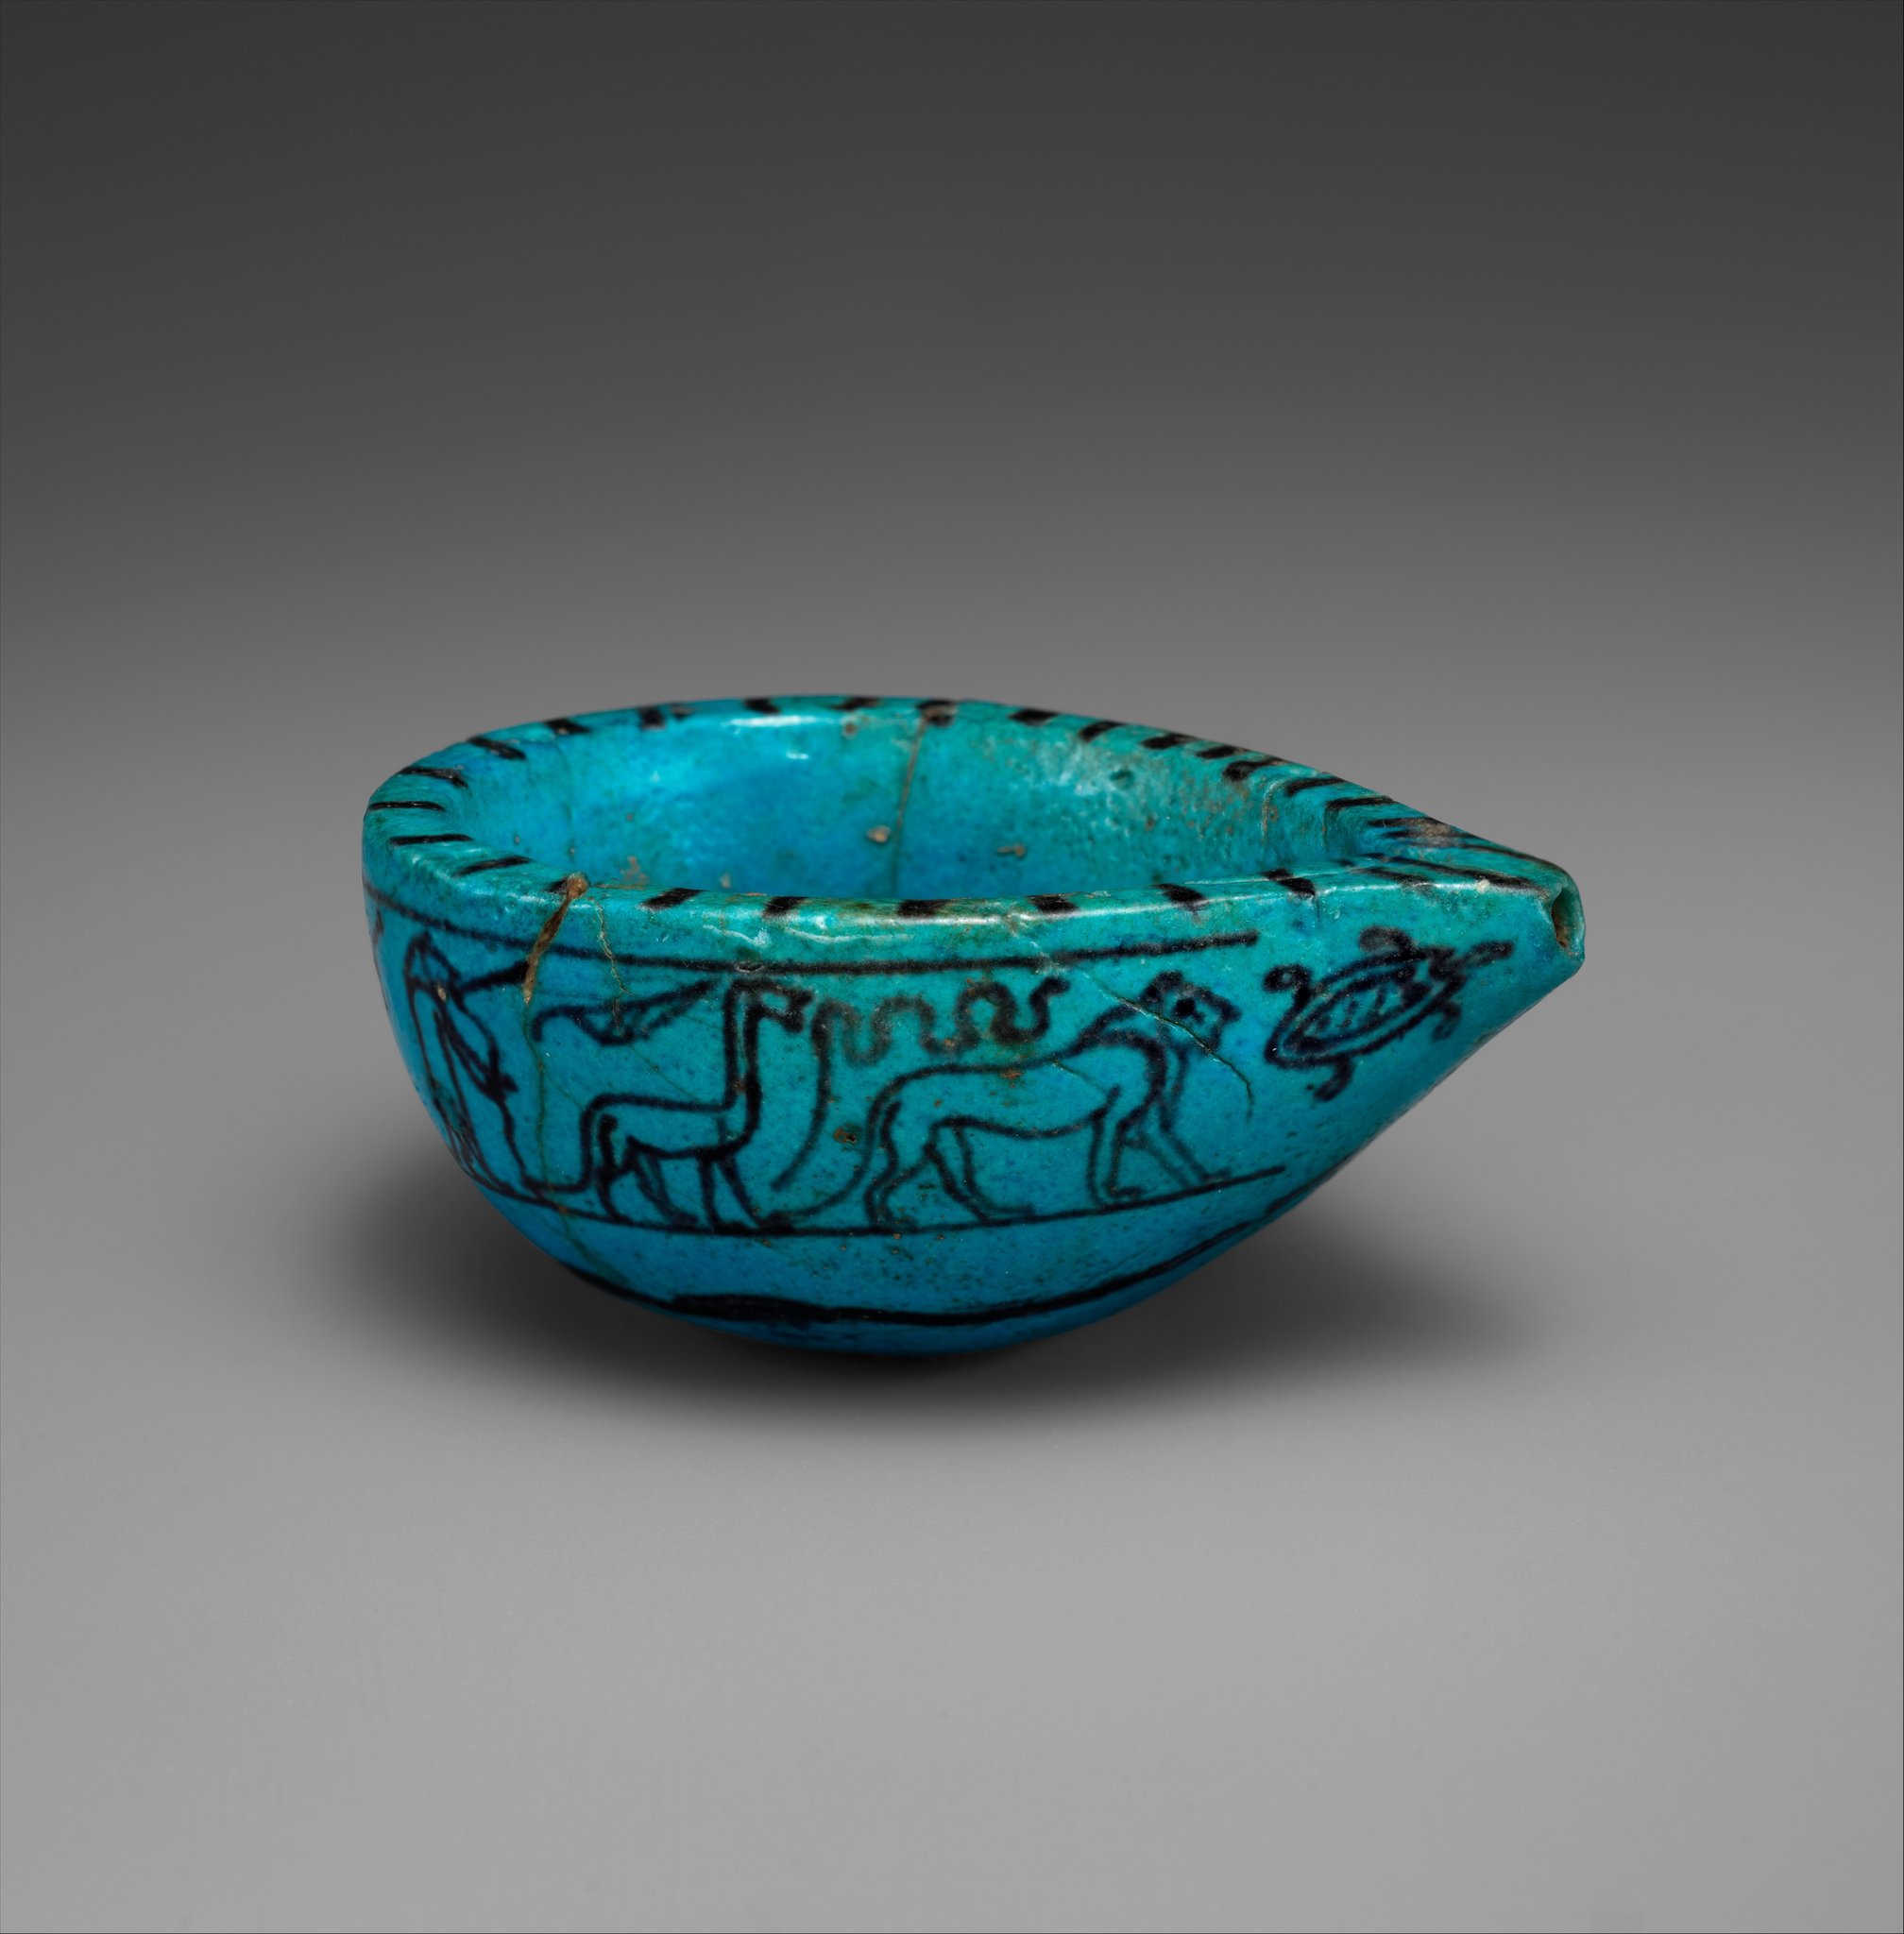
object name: cup, feeding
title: Feeding Cup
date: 1850-1700 BCE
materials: faience, paint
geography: egypt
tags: lions,snakes,turtles